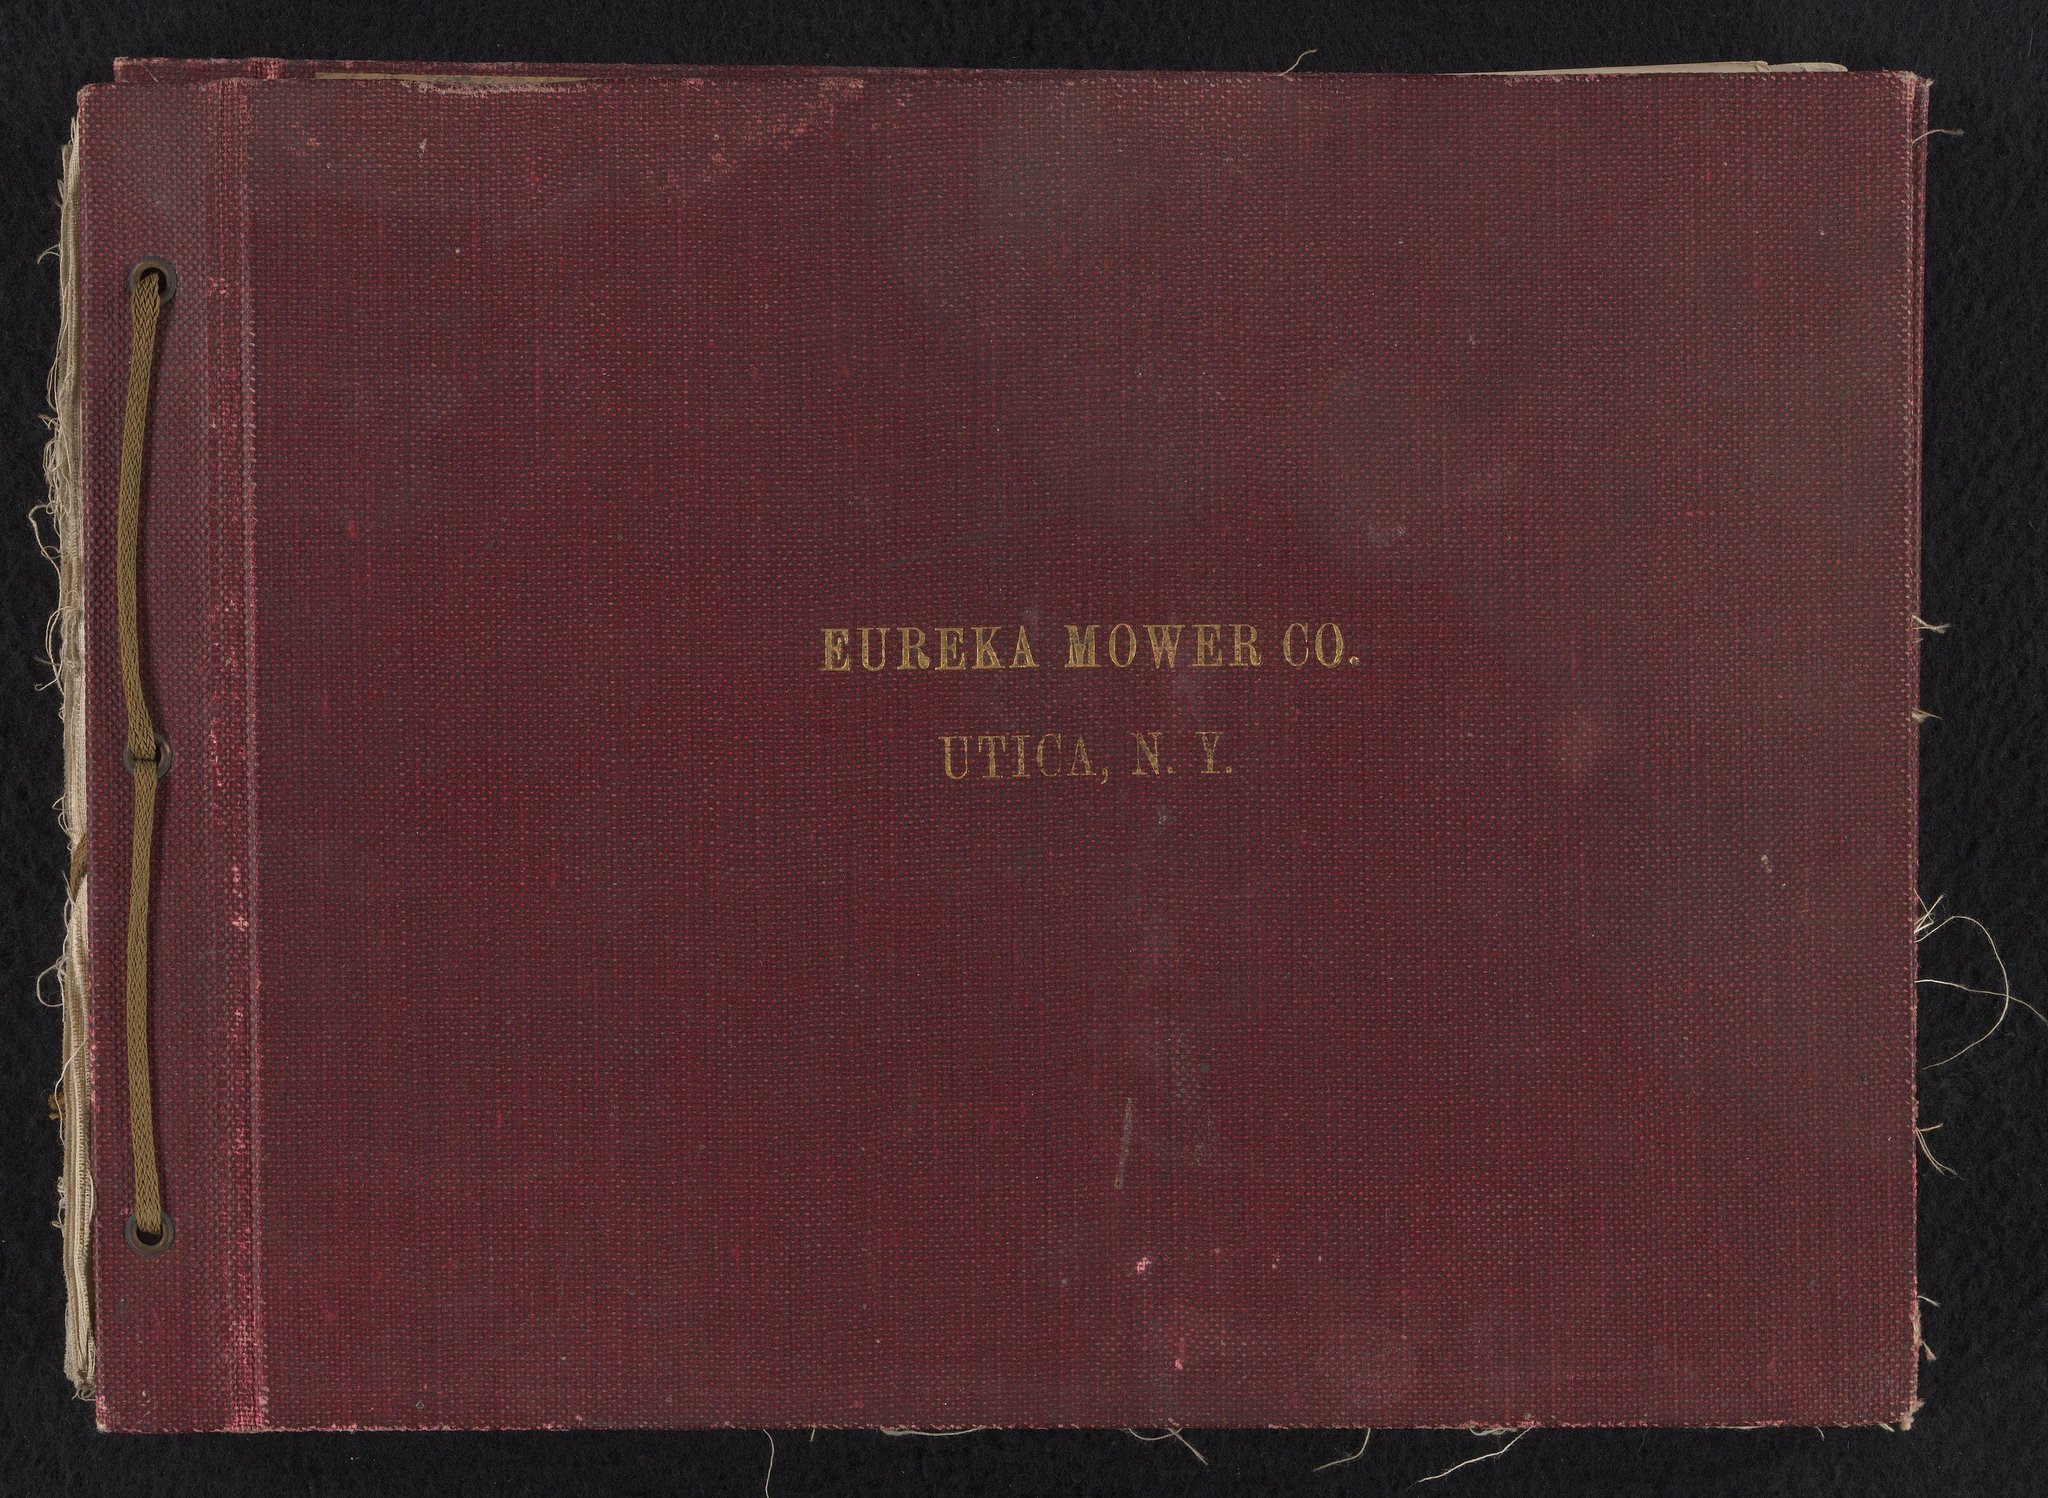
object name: book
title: Eureka Mover Co. Utica, N.Y.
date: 1915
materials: paper, linen, metal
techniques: decorated paper, gelatin silver print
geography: utica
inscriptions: date: ‘OCT/ 2007’